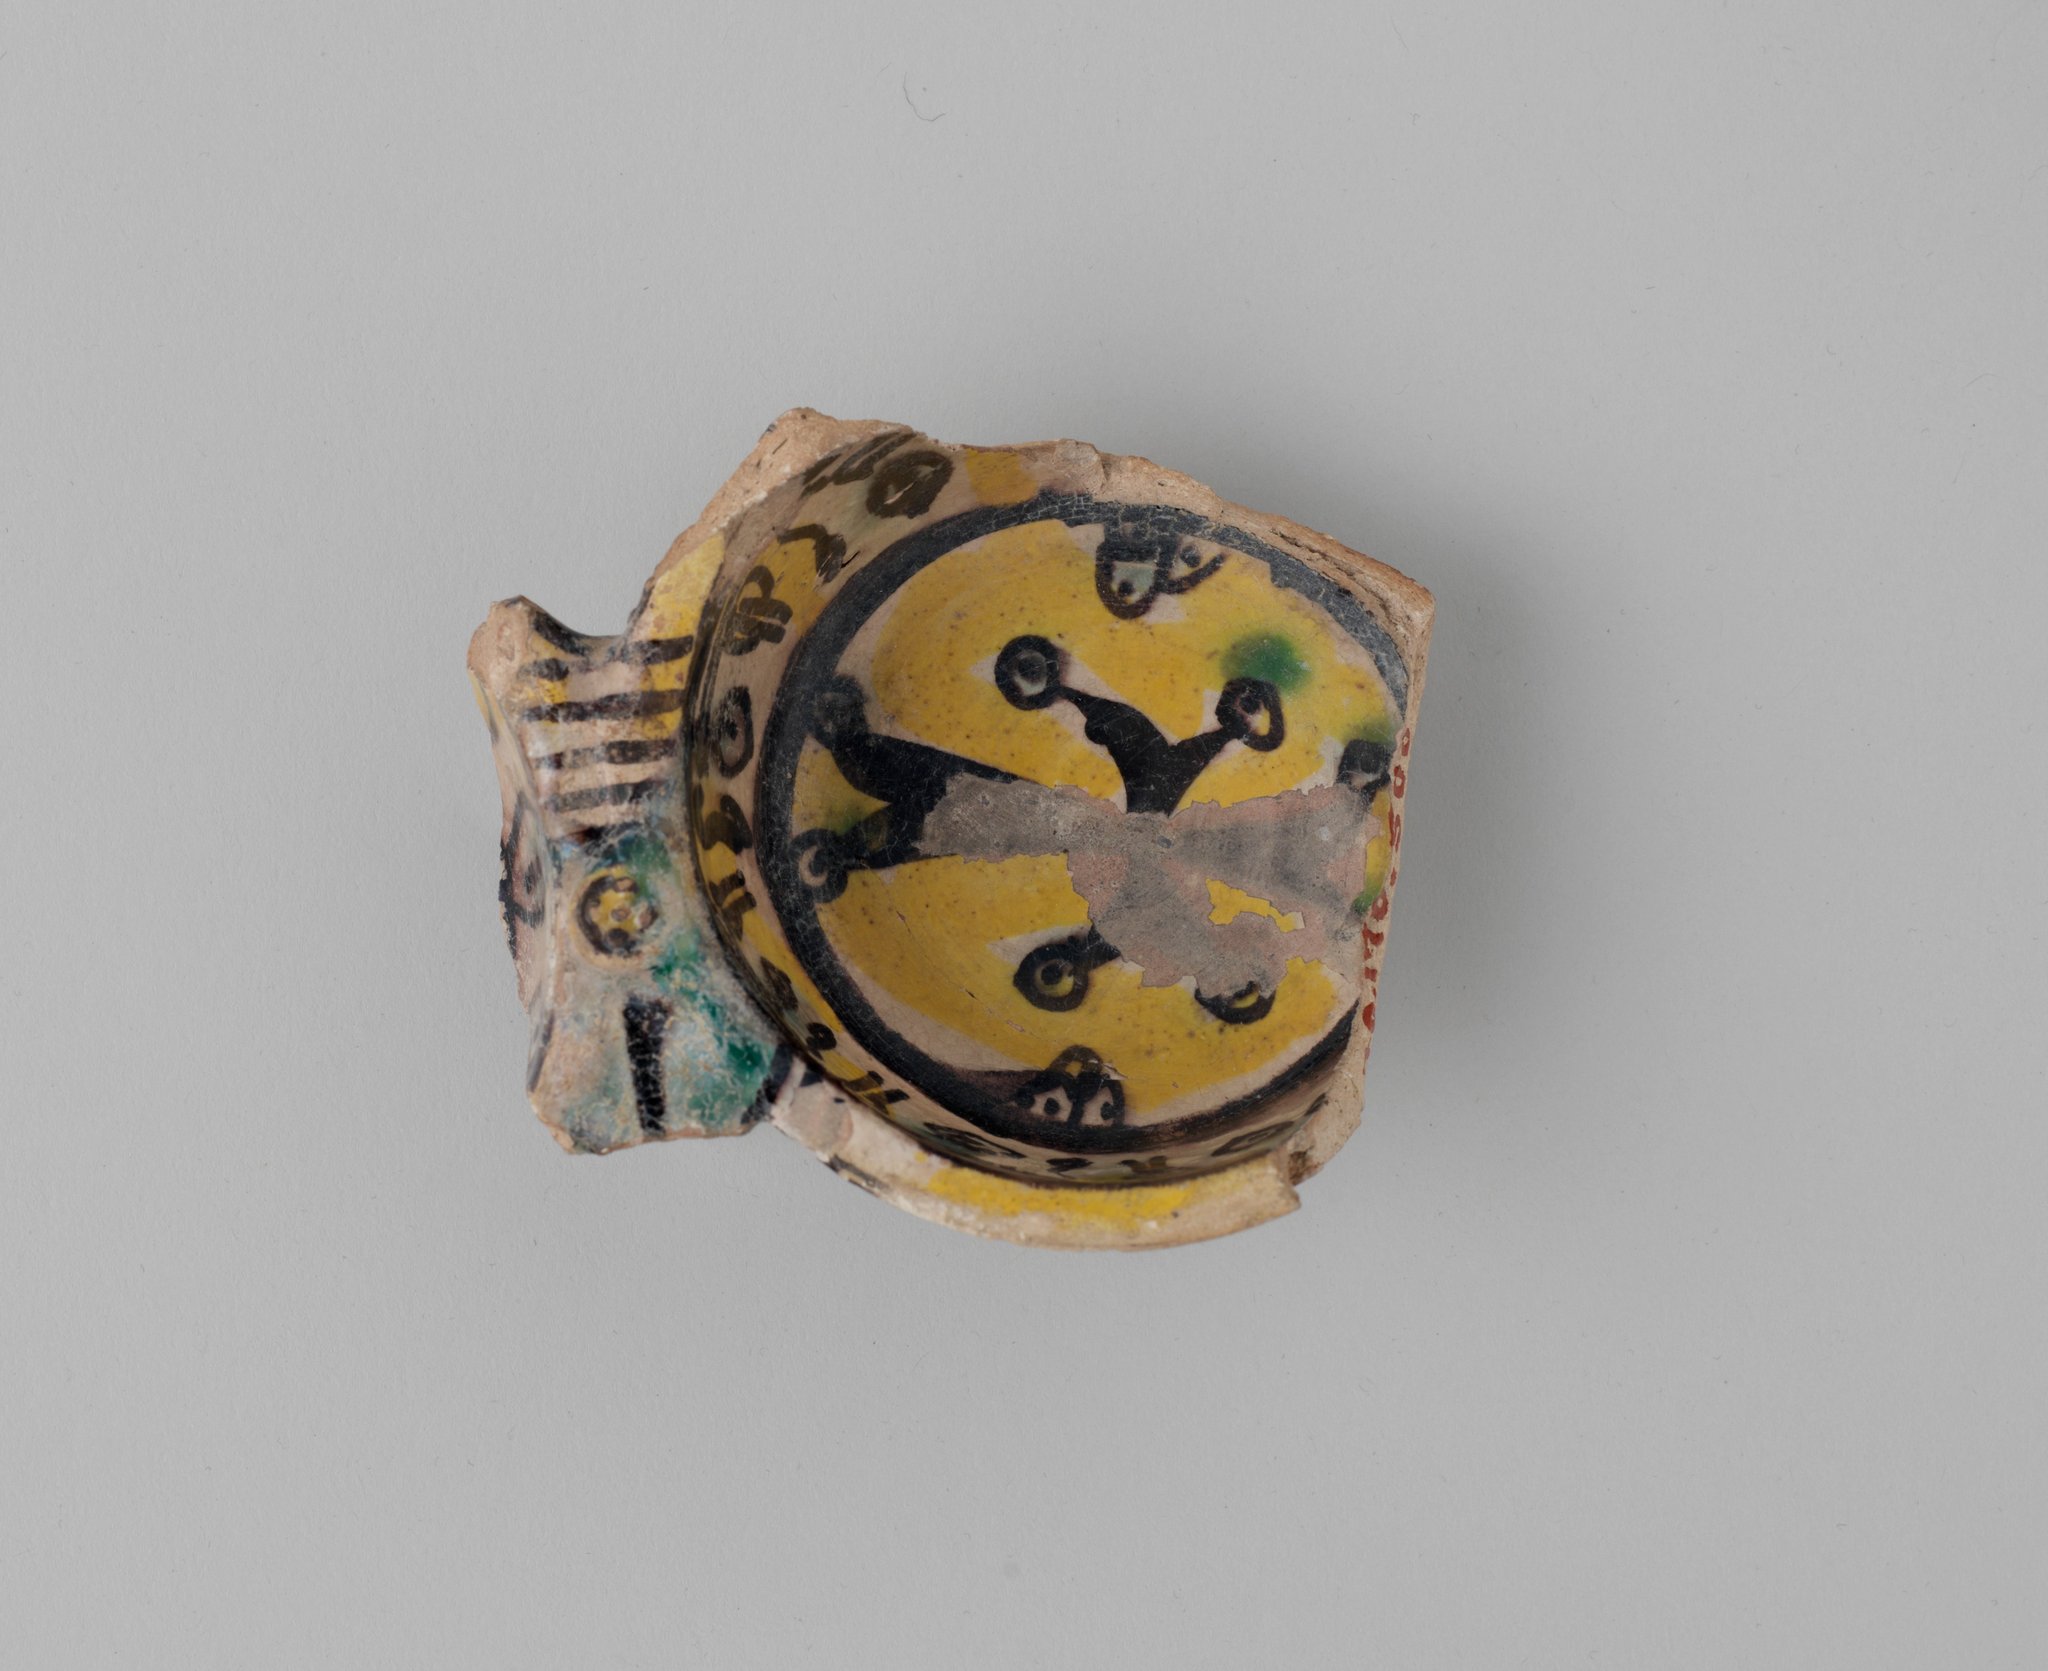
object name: fragment of a bowl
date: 801-1000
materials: earthenware, glaze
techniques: polychrome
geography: iran